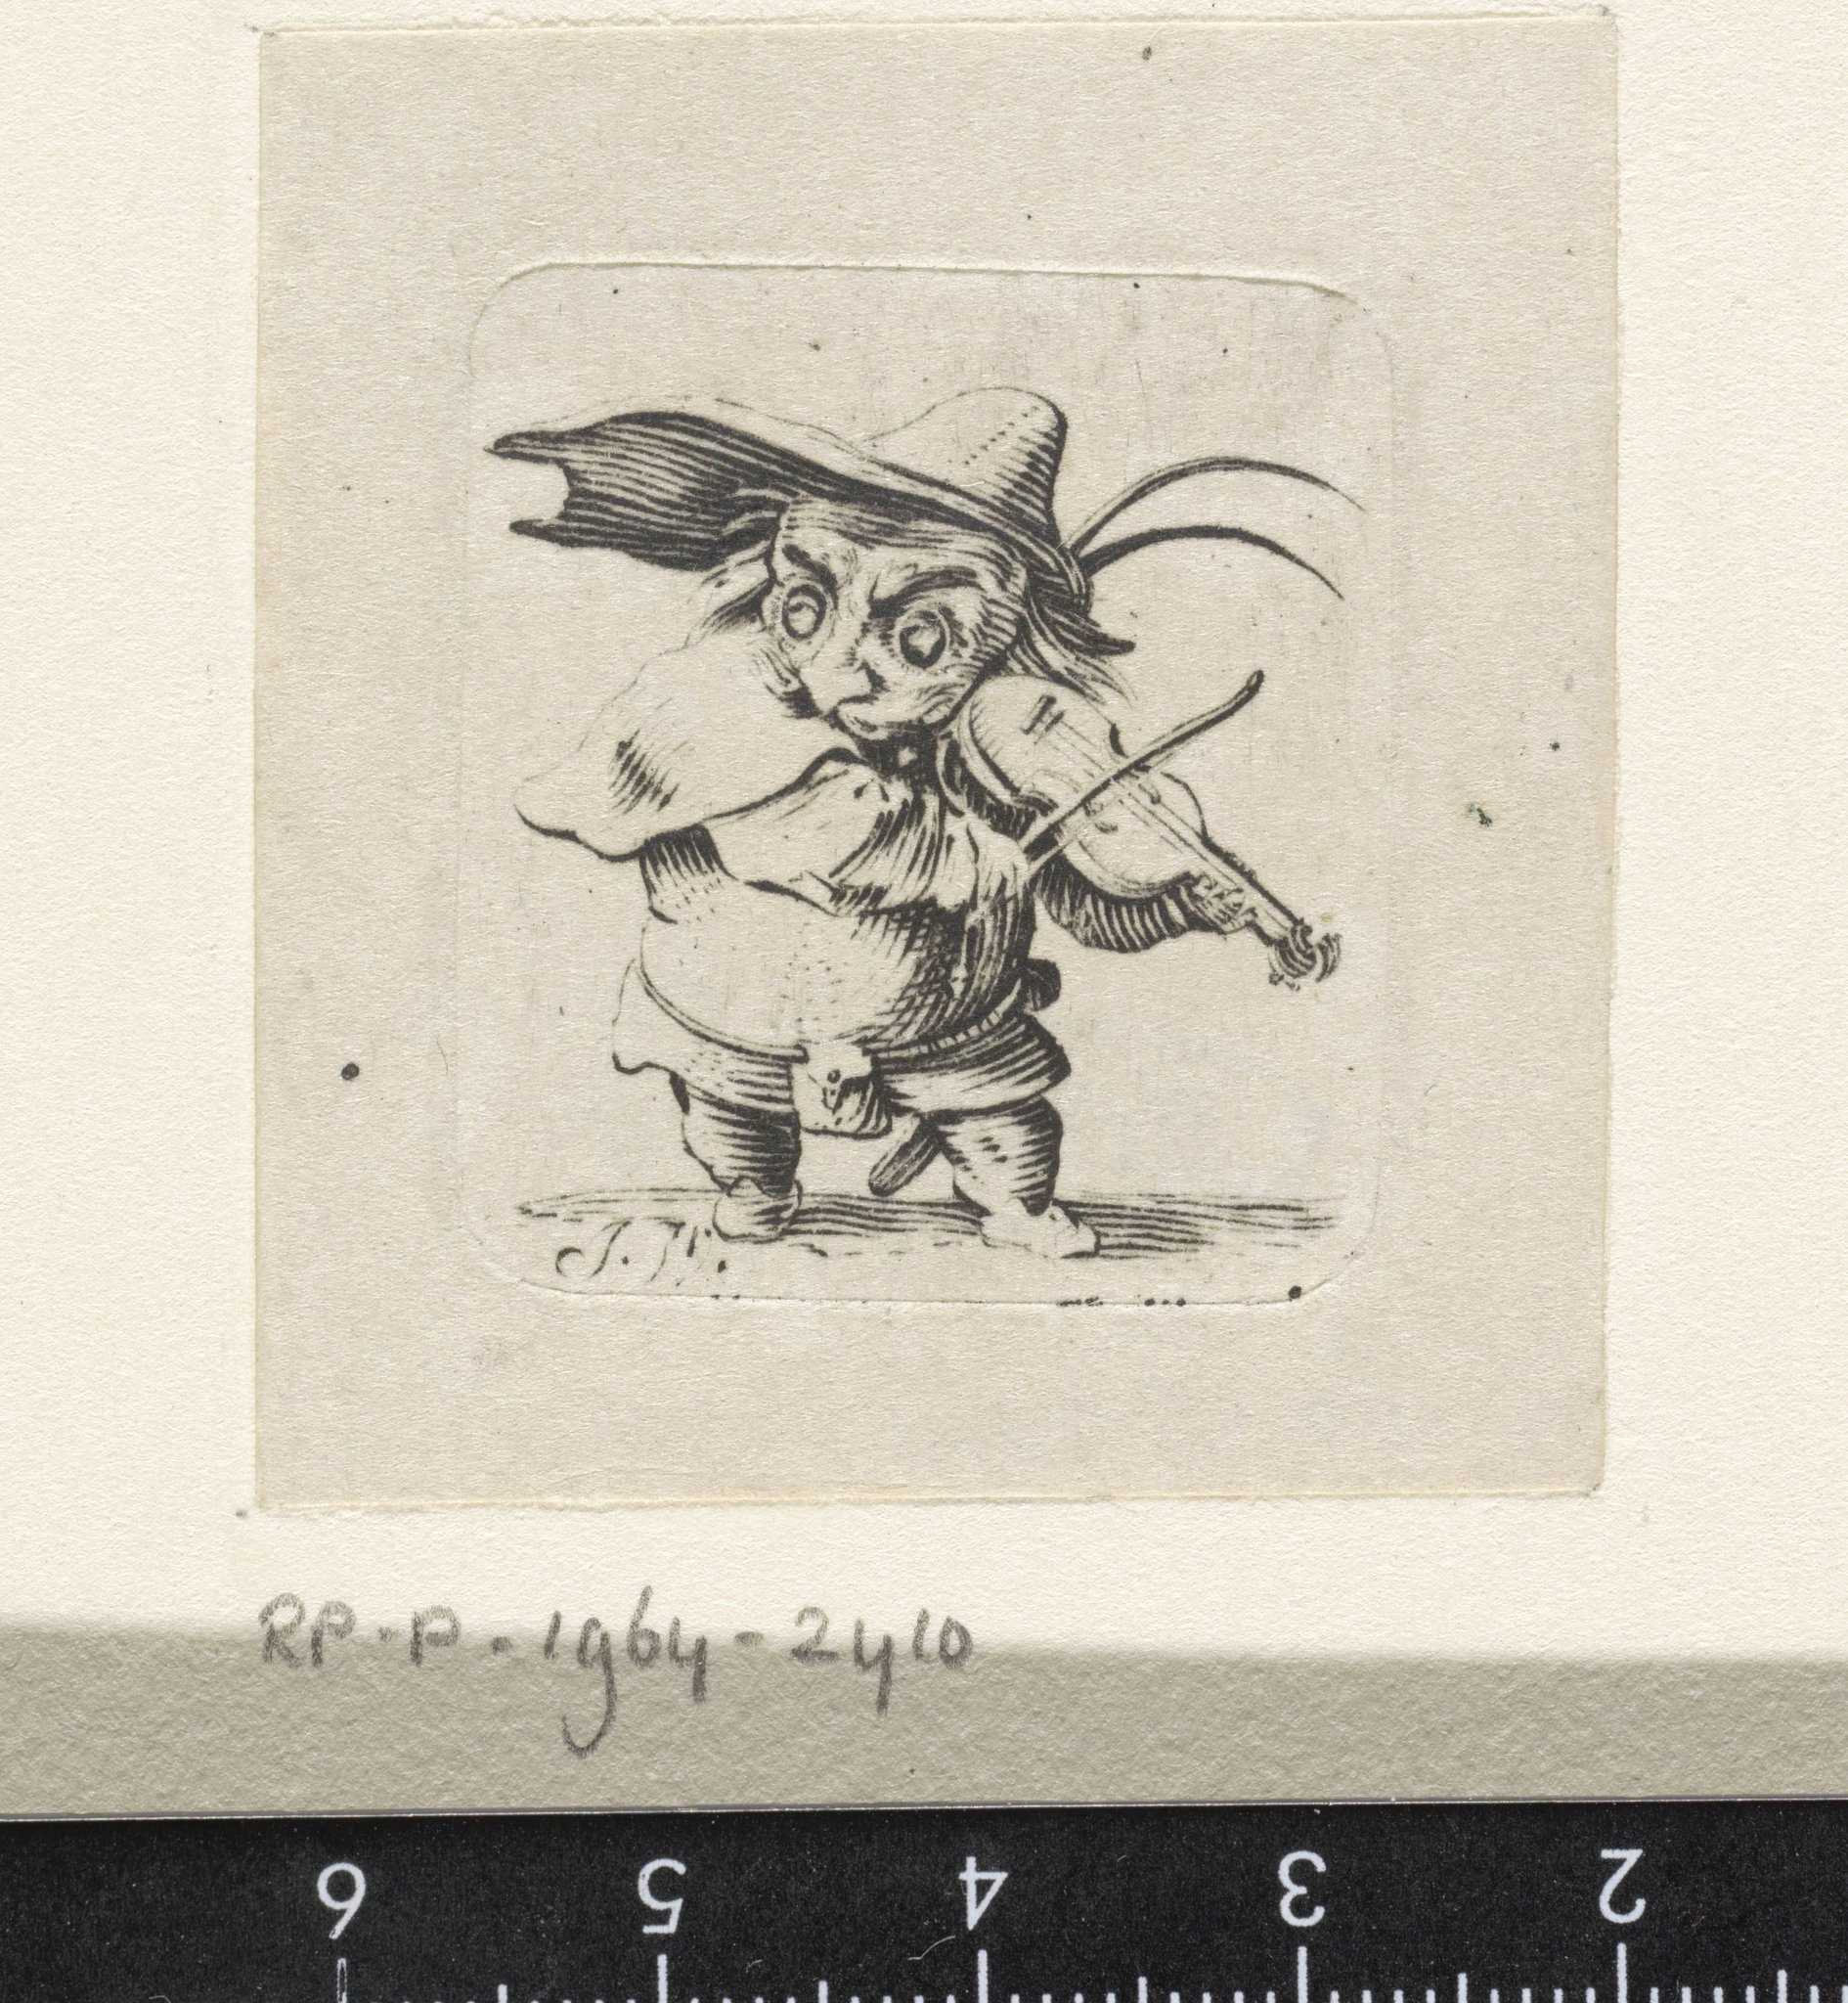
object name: print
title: Dwerg met viool en zwaard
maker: isaac walraven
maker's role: draughtsman, painter, print maker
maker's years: 1686-1765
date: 1696-1765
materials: paper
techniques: engraving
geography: amsterdam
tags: violin, fiddle, surrealia, surrealistic representations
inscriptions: collector's mark: Lugt 2228, collector's mark: Lugt 2760